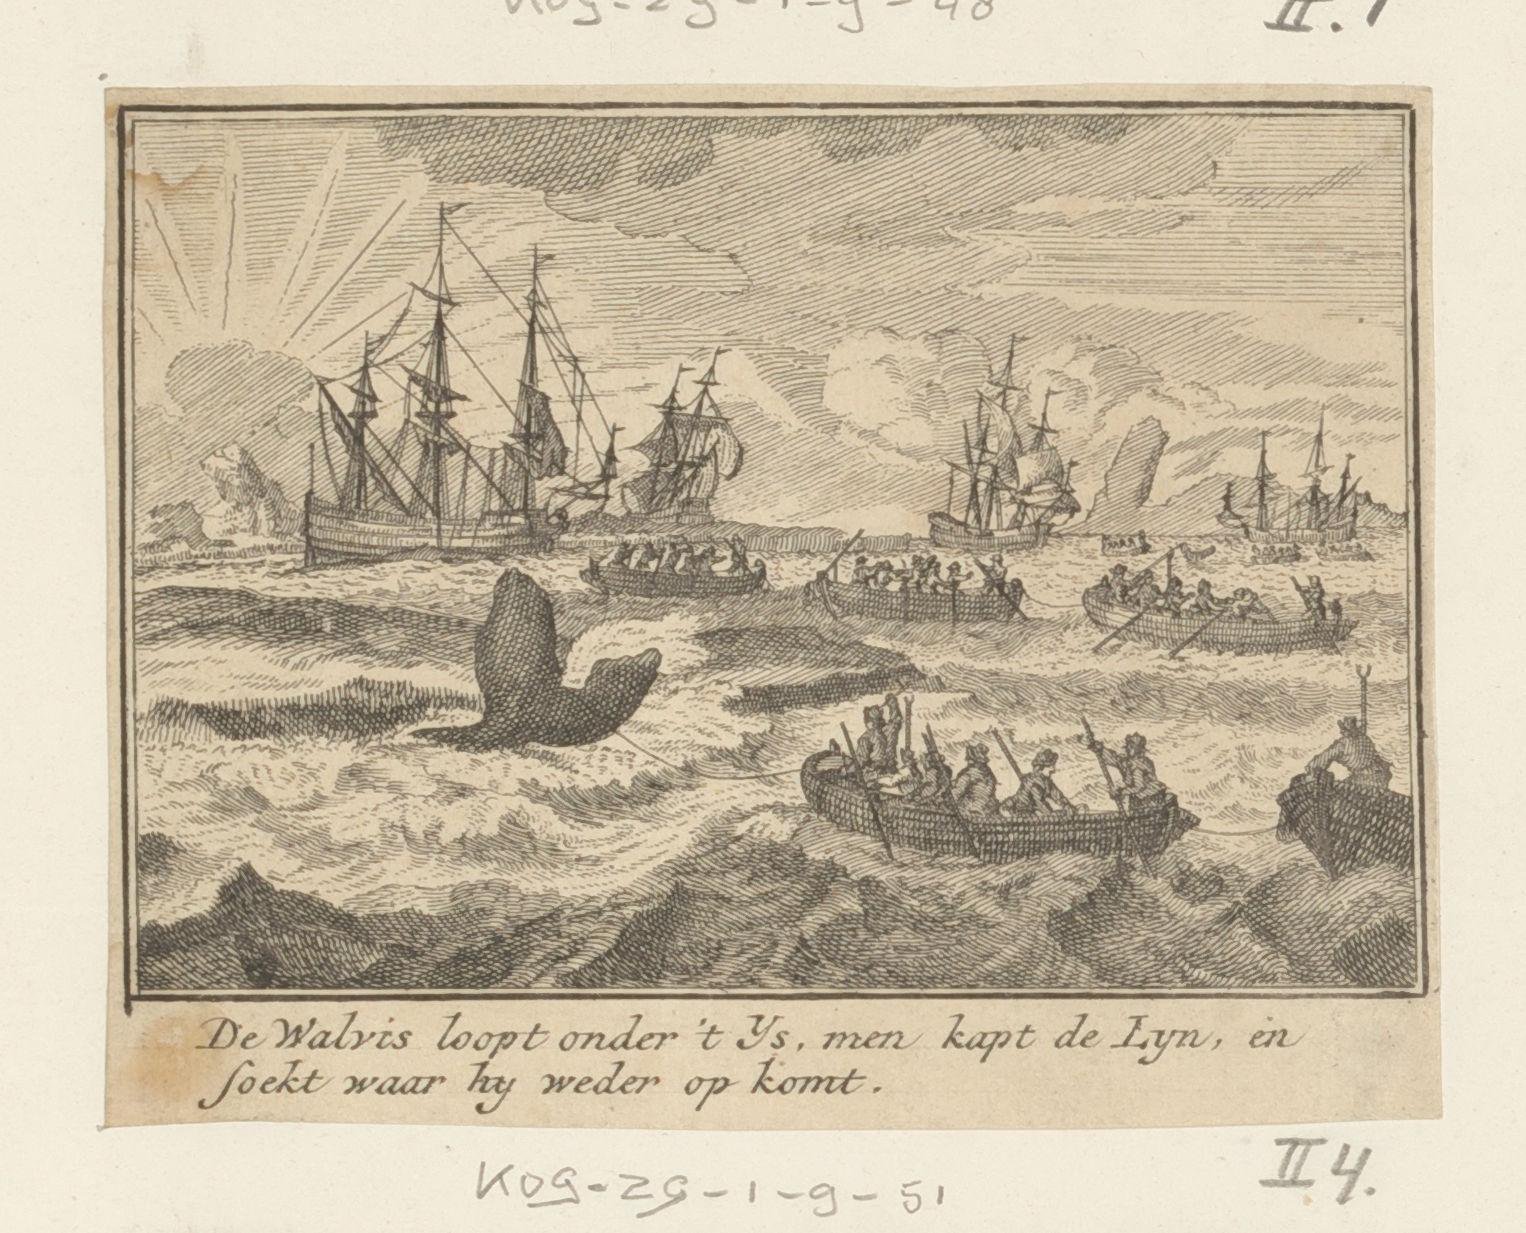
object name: print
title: Geharpoeneerde walvis duikt onder het ijs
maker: Anonymous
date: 1720-1770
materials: paper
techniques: engraving, etching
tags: ships (in general), whale fishery, whaling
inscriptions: collector's mark: Lugt 1641, stamp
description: Prenten zijn een verkleinde versie van de serie Groote Visserij, Visschers Atlas tot Amsterdam. Prenten door Adolf van der Laan, naar tekeningen van Sieuwert van der Meulen en uitgegeven door Pieter Schenk II. De serie bestaat uit zeventien platen over de haringvisserij en zestien platen over de walvisvangst. De serie is waarschijnlijk rond 1720 uitgegeven. De kleine prenten werden met vier voorstellingen op een plaat gedrukt. Elke afbeelding werd genummerd.